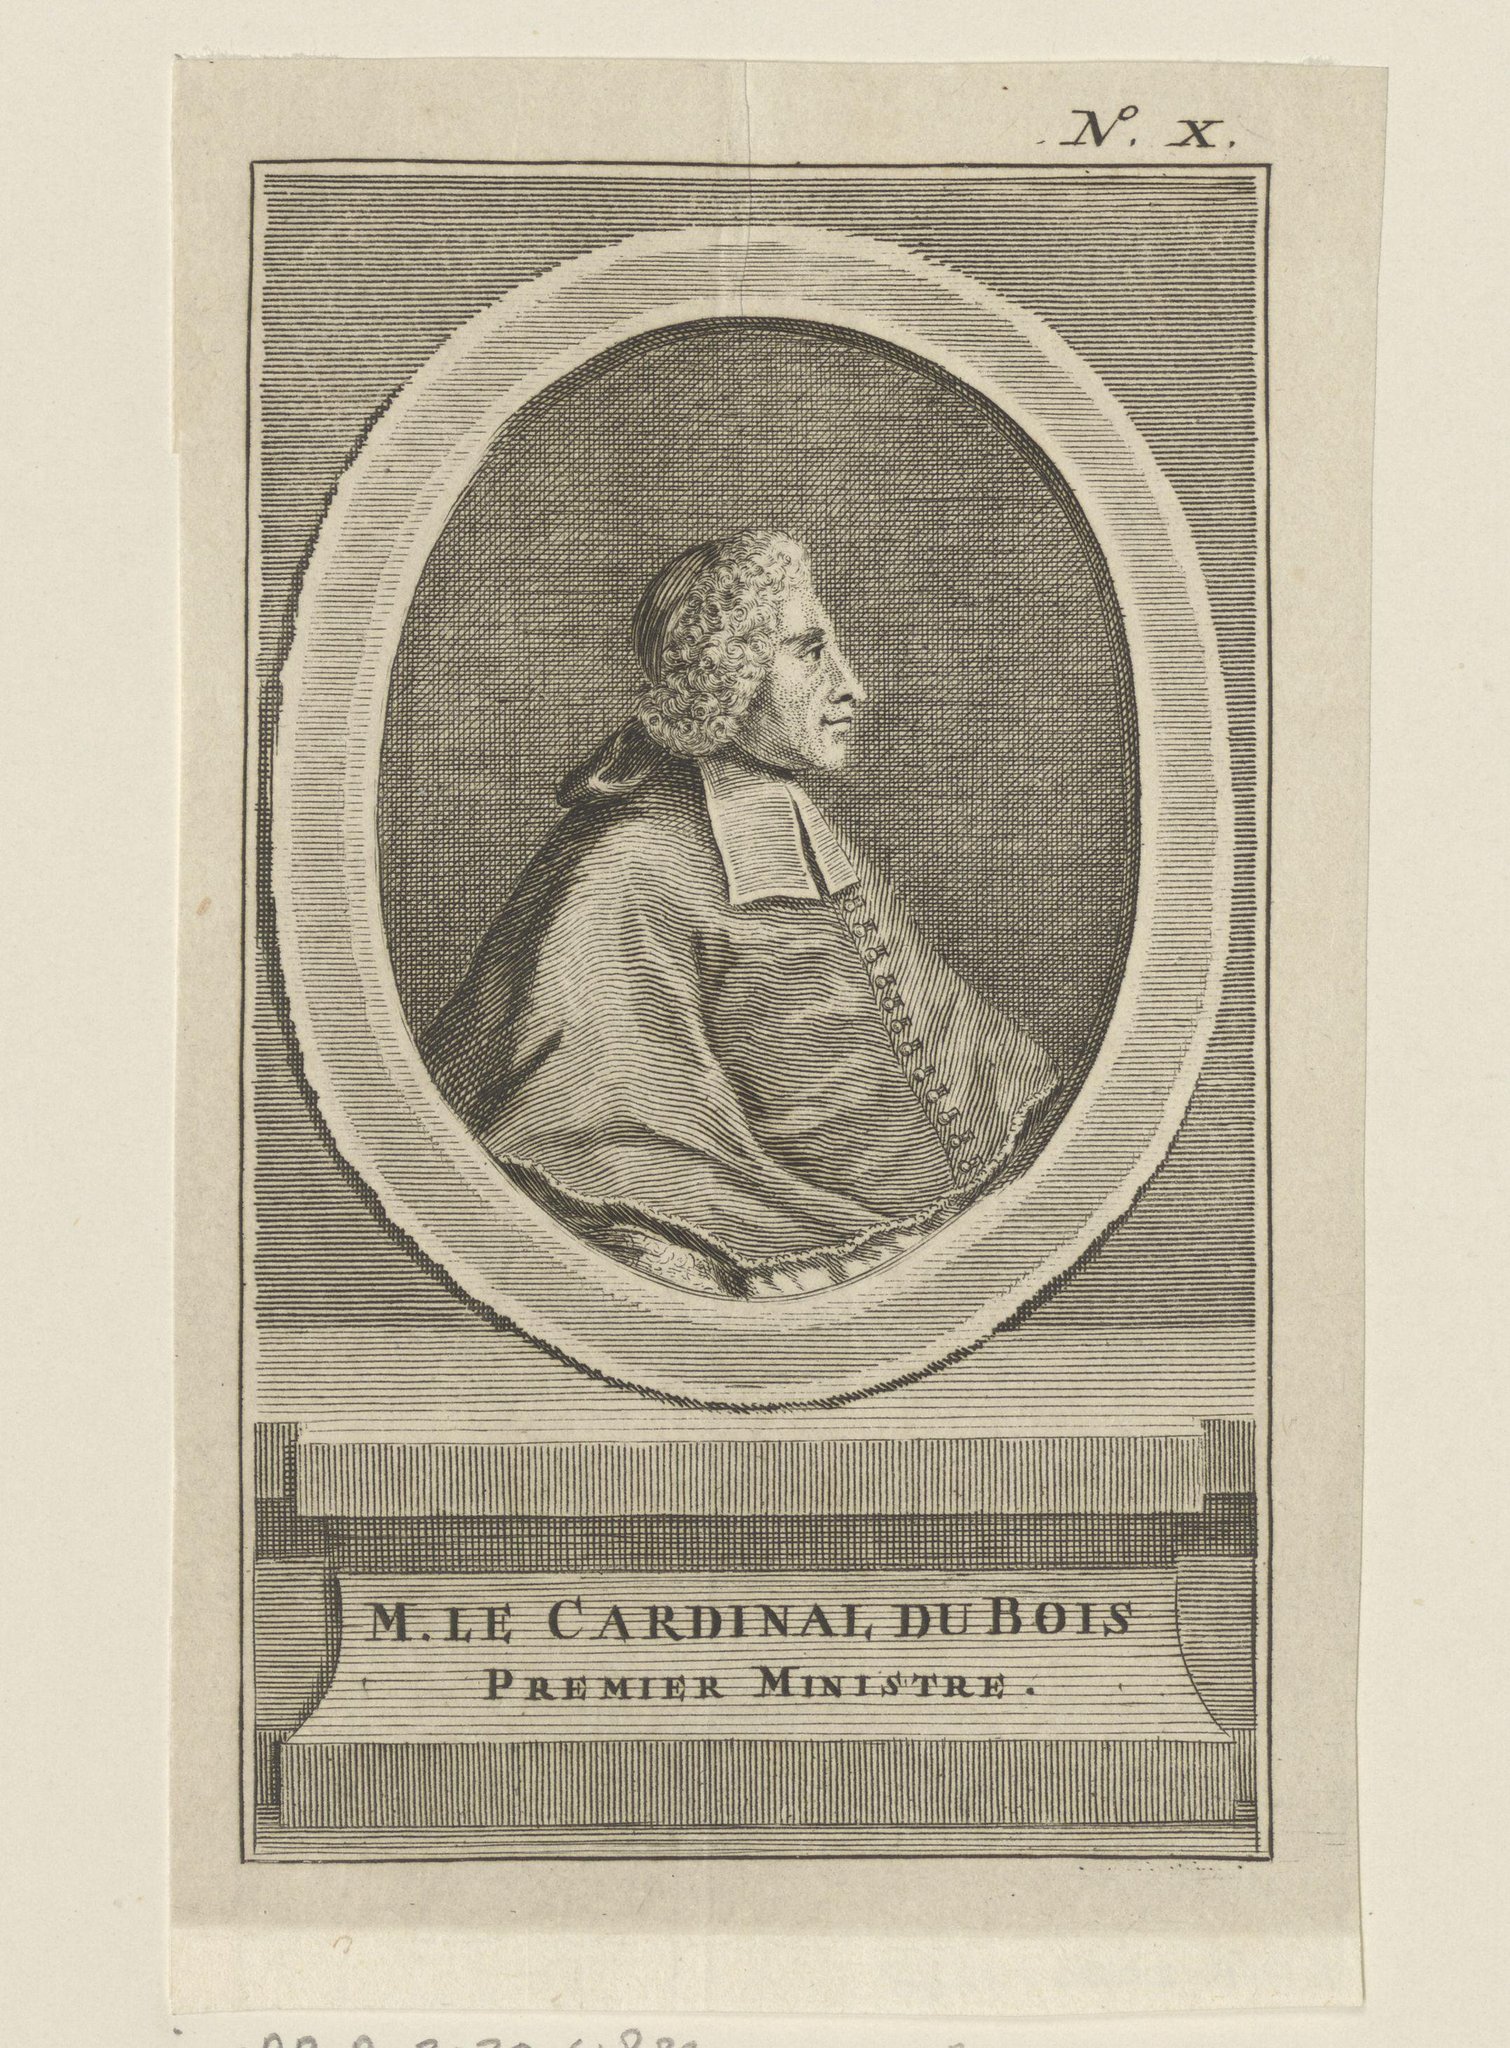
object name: print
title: Portret van staatsman en kardinaal Guillaume Dubois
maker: Anonymous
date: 1700-1799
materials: paper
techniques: engraving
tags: official; civil servant; functionary (in general), cardinal, historical persons